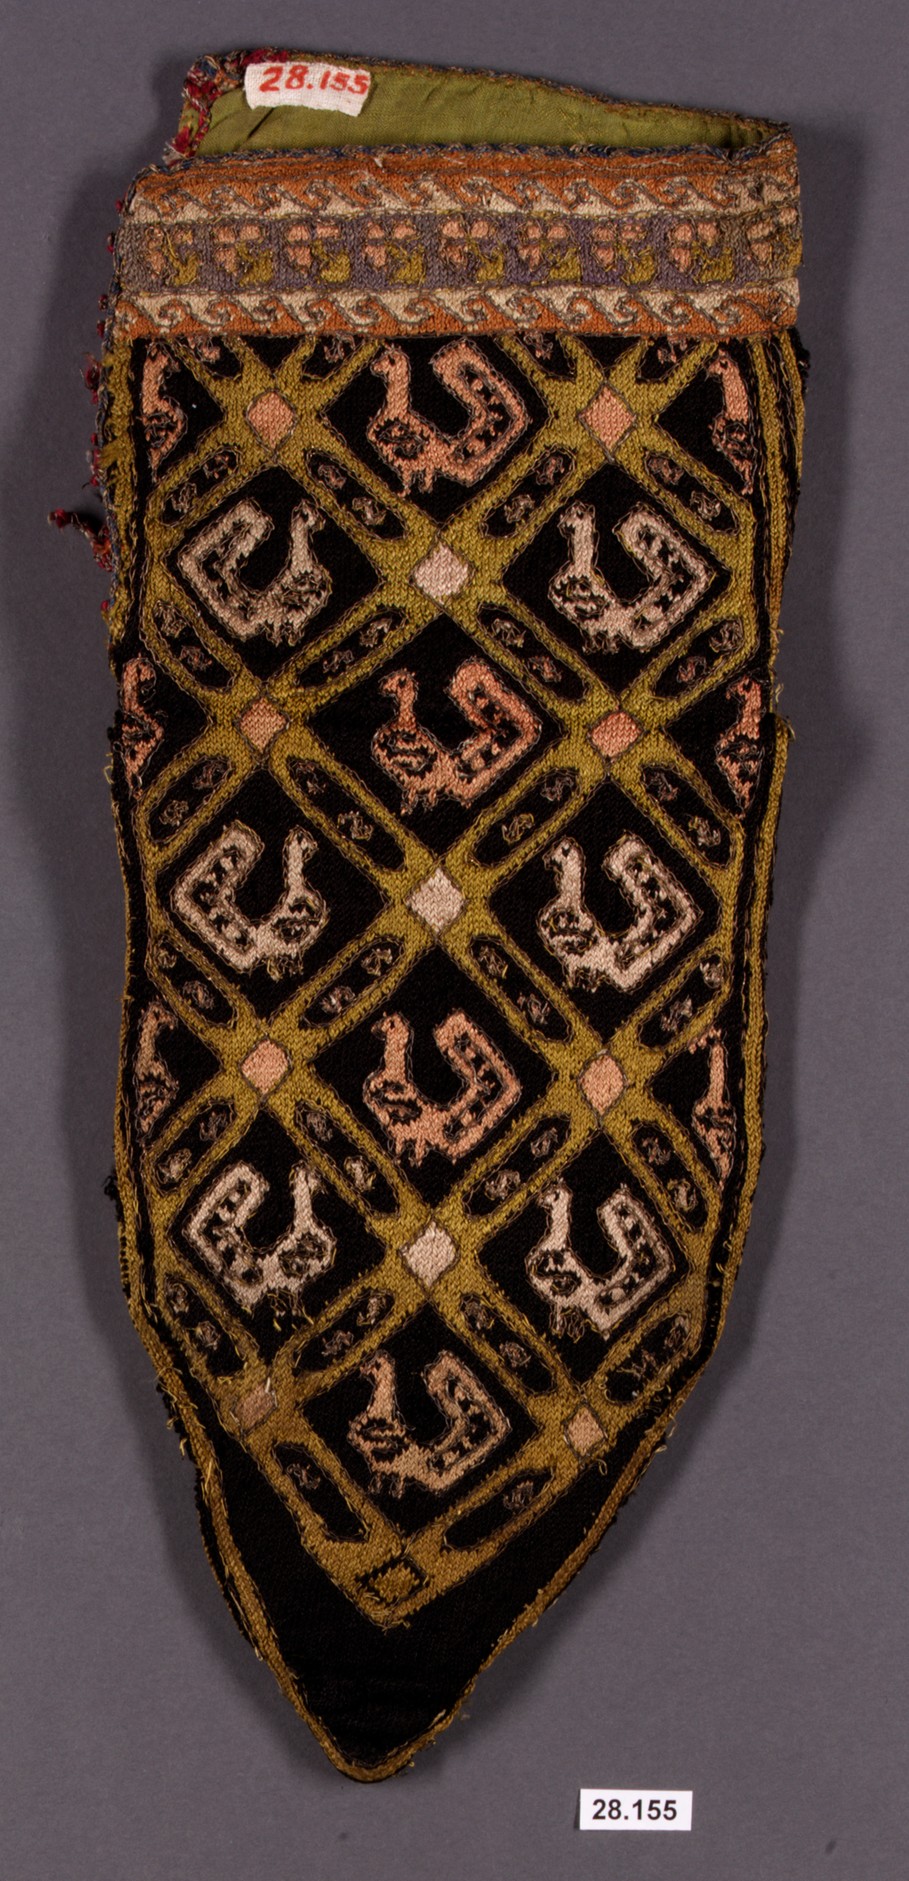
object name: sock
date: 1767-1800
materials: metal thread, silk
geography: iran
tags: peacocks